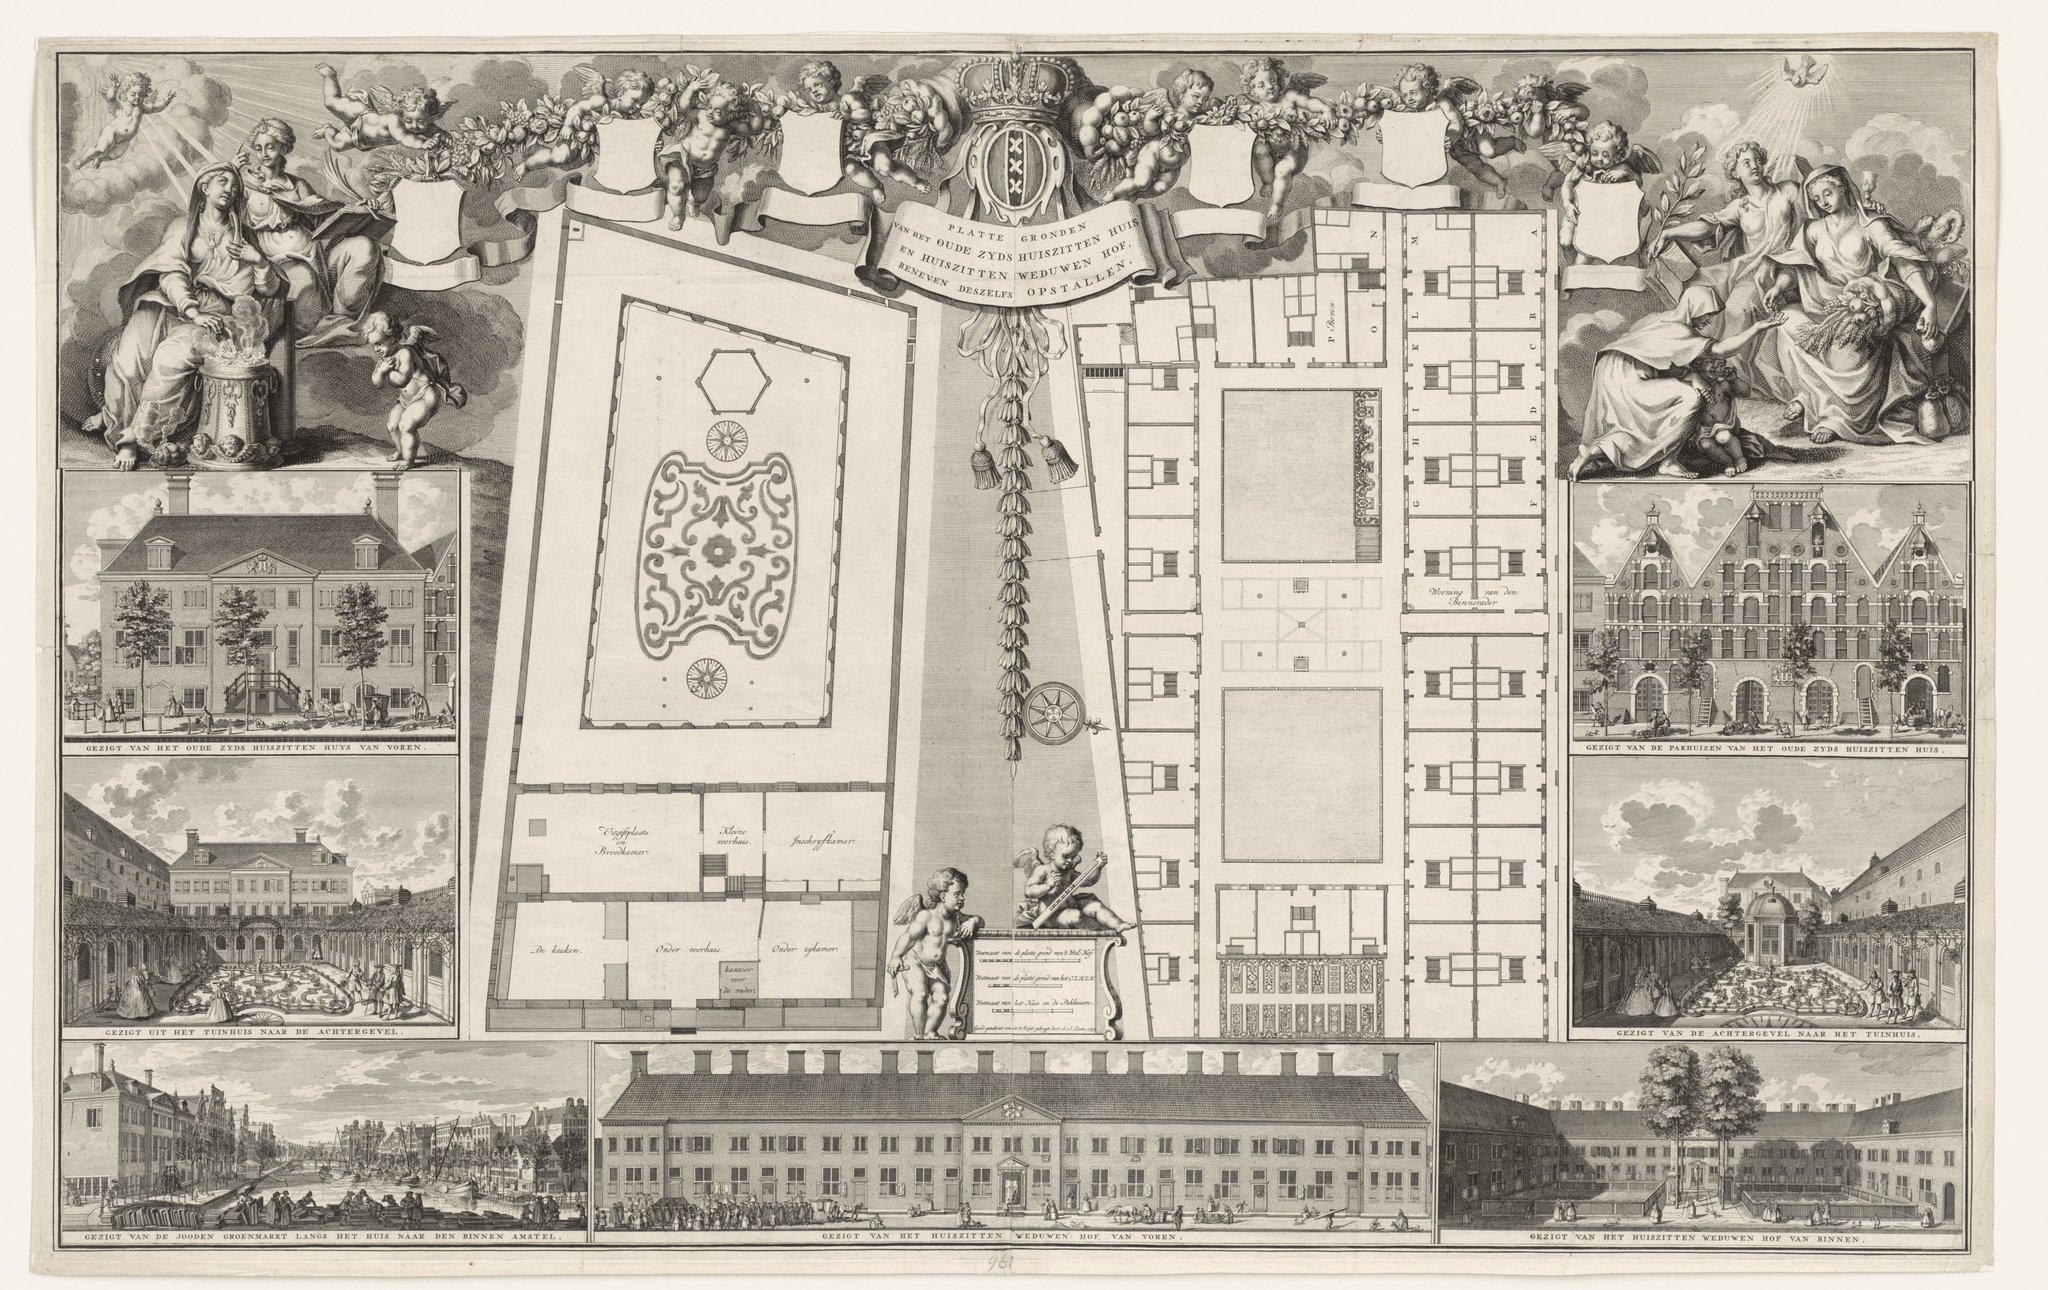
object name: print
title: Oude-Zijds-Huiszittenhuis, en Huiszitten Weduwenhof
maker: adolf van der laan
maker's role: draughtsman, print maker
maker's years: 1689-1742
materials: paper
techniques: etching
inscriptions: date